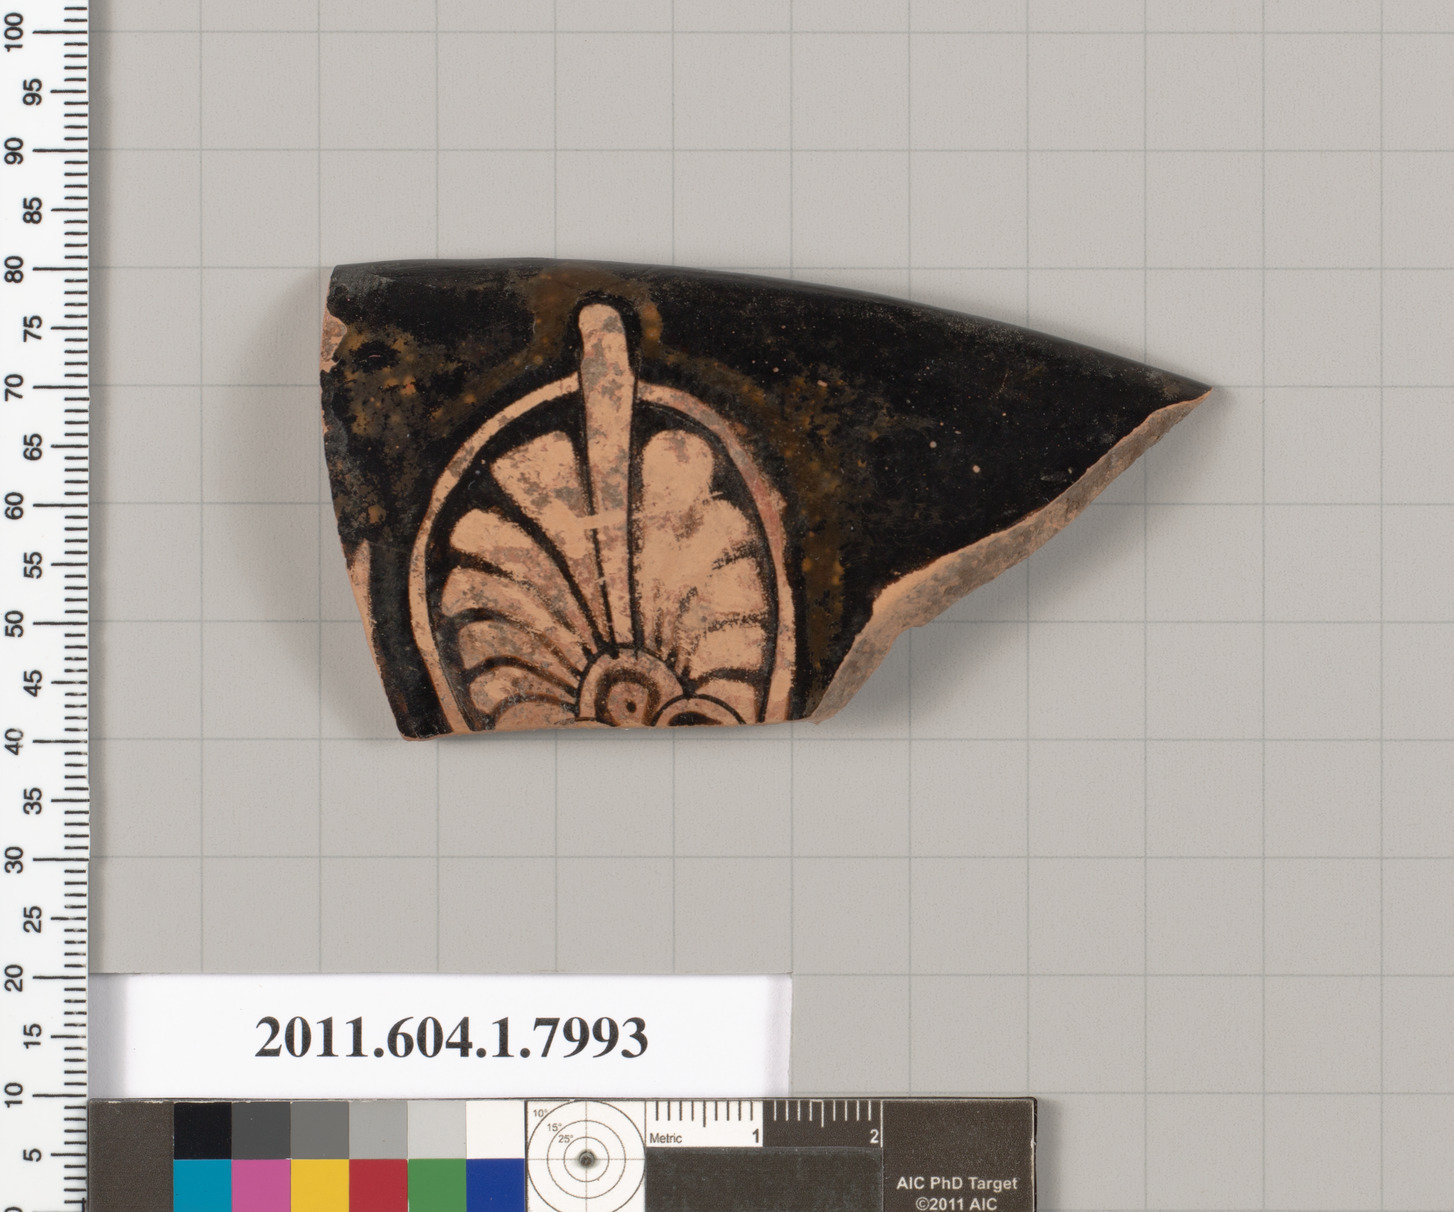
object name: kylix fragment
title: Terracotta fragment of a kylix (drinking cup)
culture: greek, attic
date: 460-450 BCE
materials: terracotta